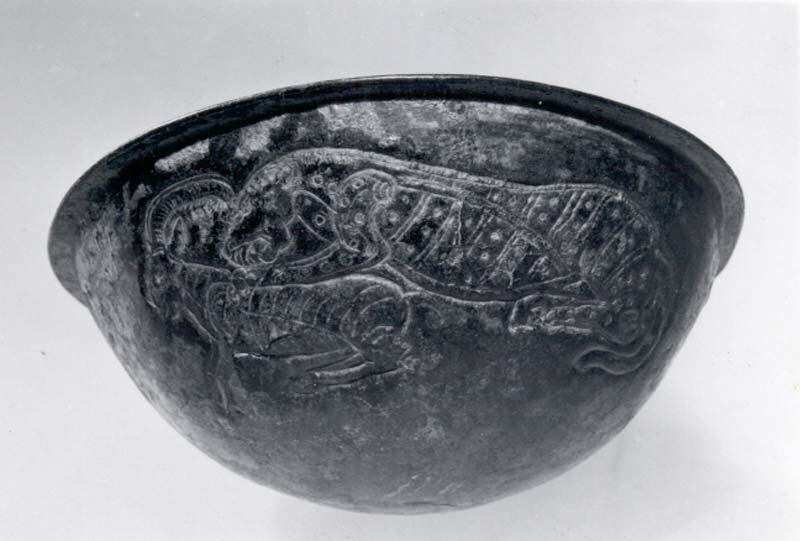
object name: bowl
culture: iranian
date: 1000-700 BCE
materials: bronze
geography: northwestern iran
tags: animals,hunting